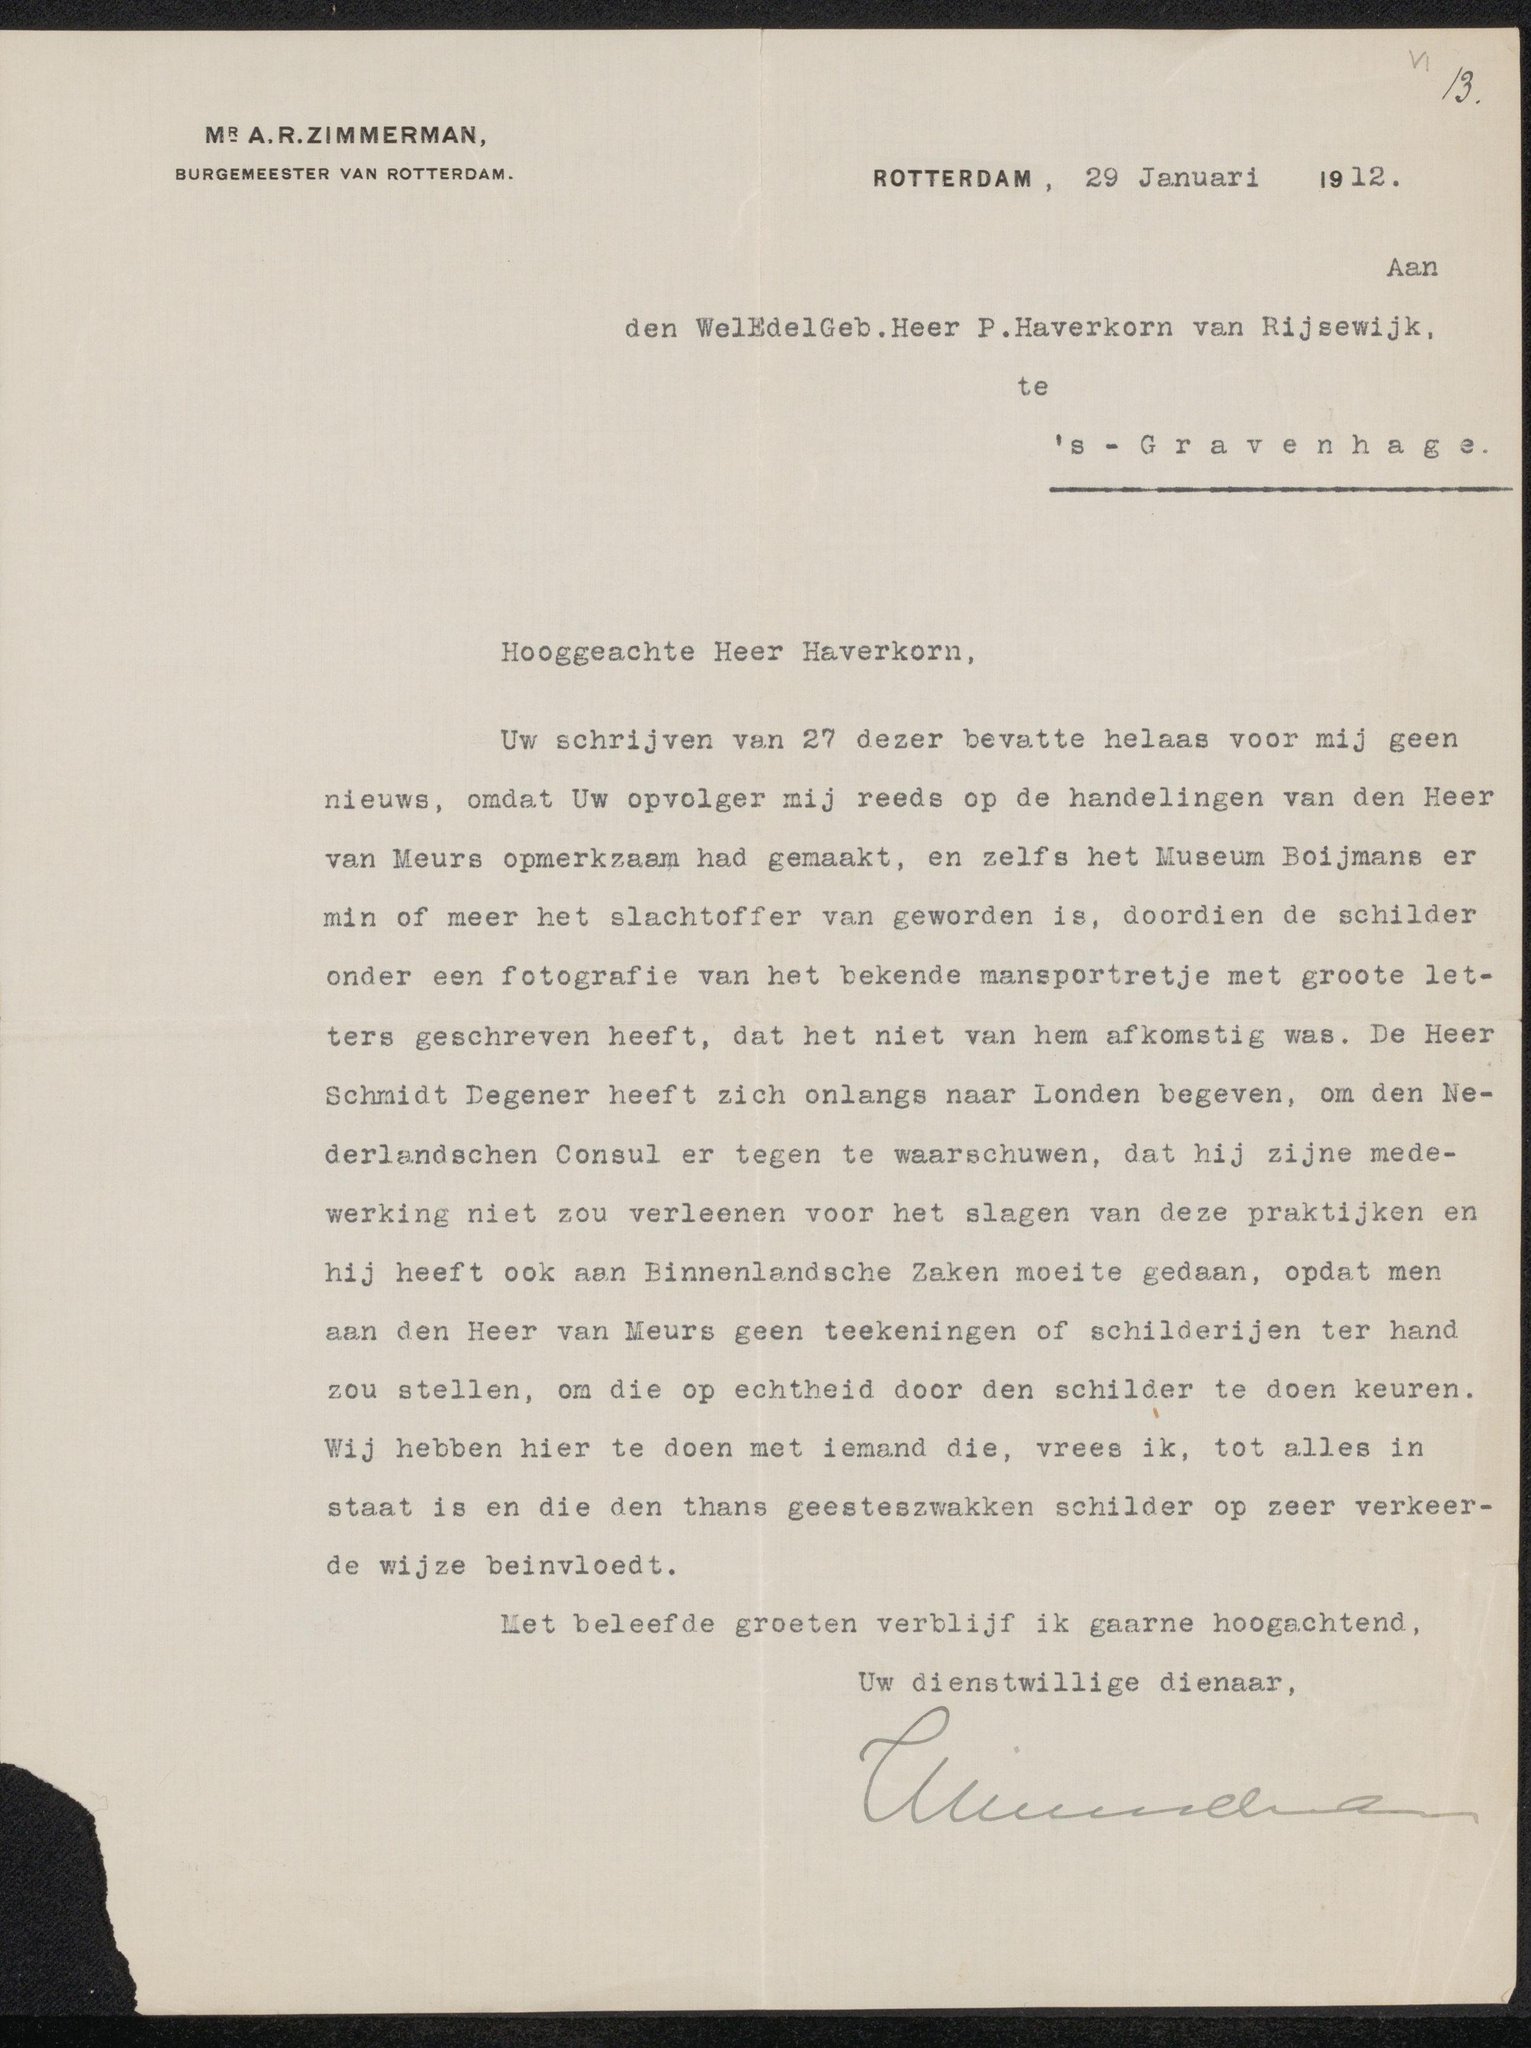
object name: letter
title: Brief aan Pieter Haverkorn van Rijsewijk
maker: alfred rudolph zimmerman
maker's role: mayor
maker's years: 1869-1939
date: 1912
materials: ink, paper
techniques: pen, printing, typewriting, writing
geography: rotterdam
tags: the hague, london, painter, print maker, draughtsman, matthijs maris, pieter haverkorn van rijsewijk, rotterdam, amsterdam, frederik schmidt-degener, artist, willem jan gerrit van meurs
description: Brief is bewaard bij correspondentie aan Pieter Haverkorn van Rijsewijk betreffende Matthijs Maris.